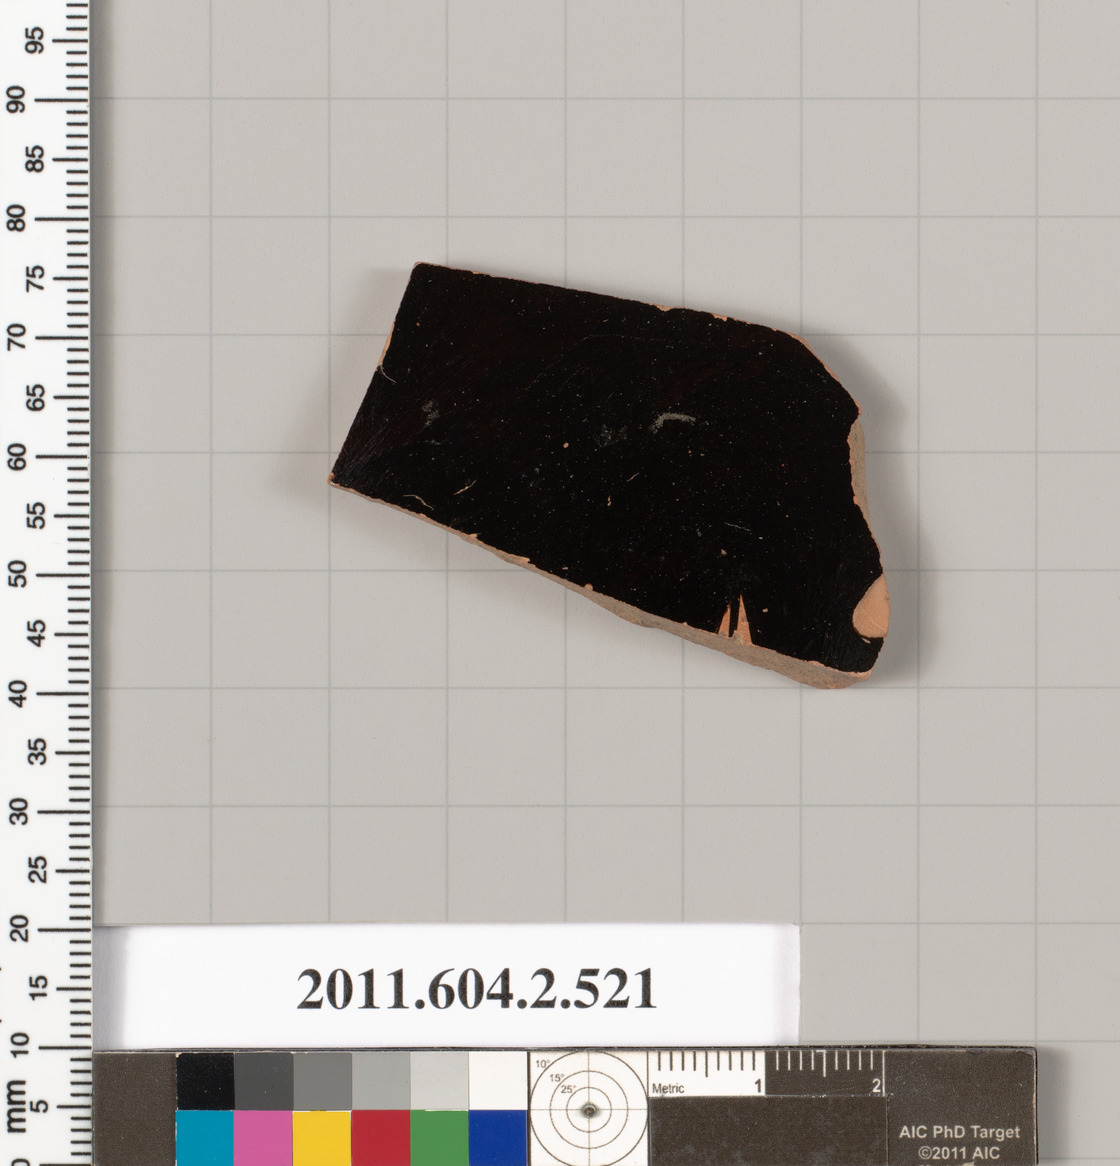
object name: column krater fragment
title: Terracotta fragment of a column-krater (bowl for mixing wine and water)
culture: greek, attic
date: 460-440 BCE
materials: terracotta